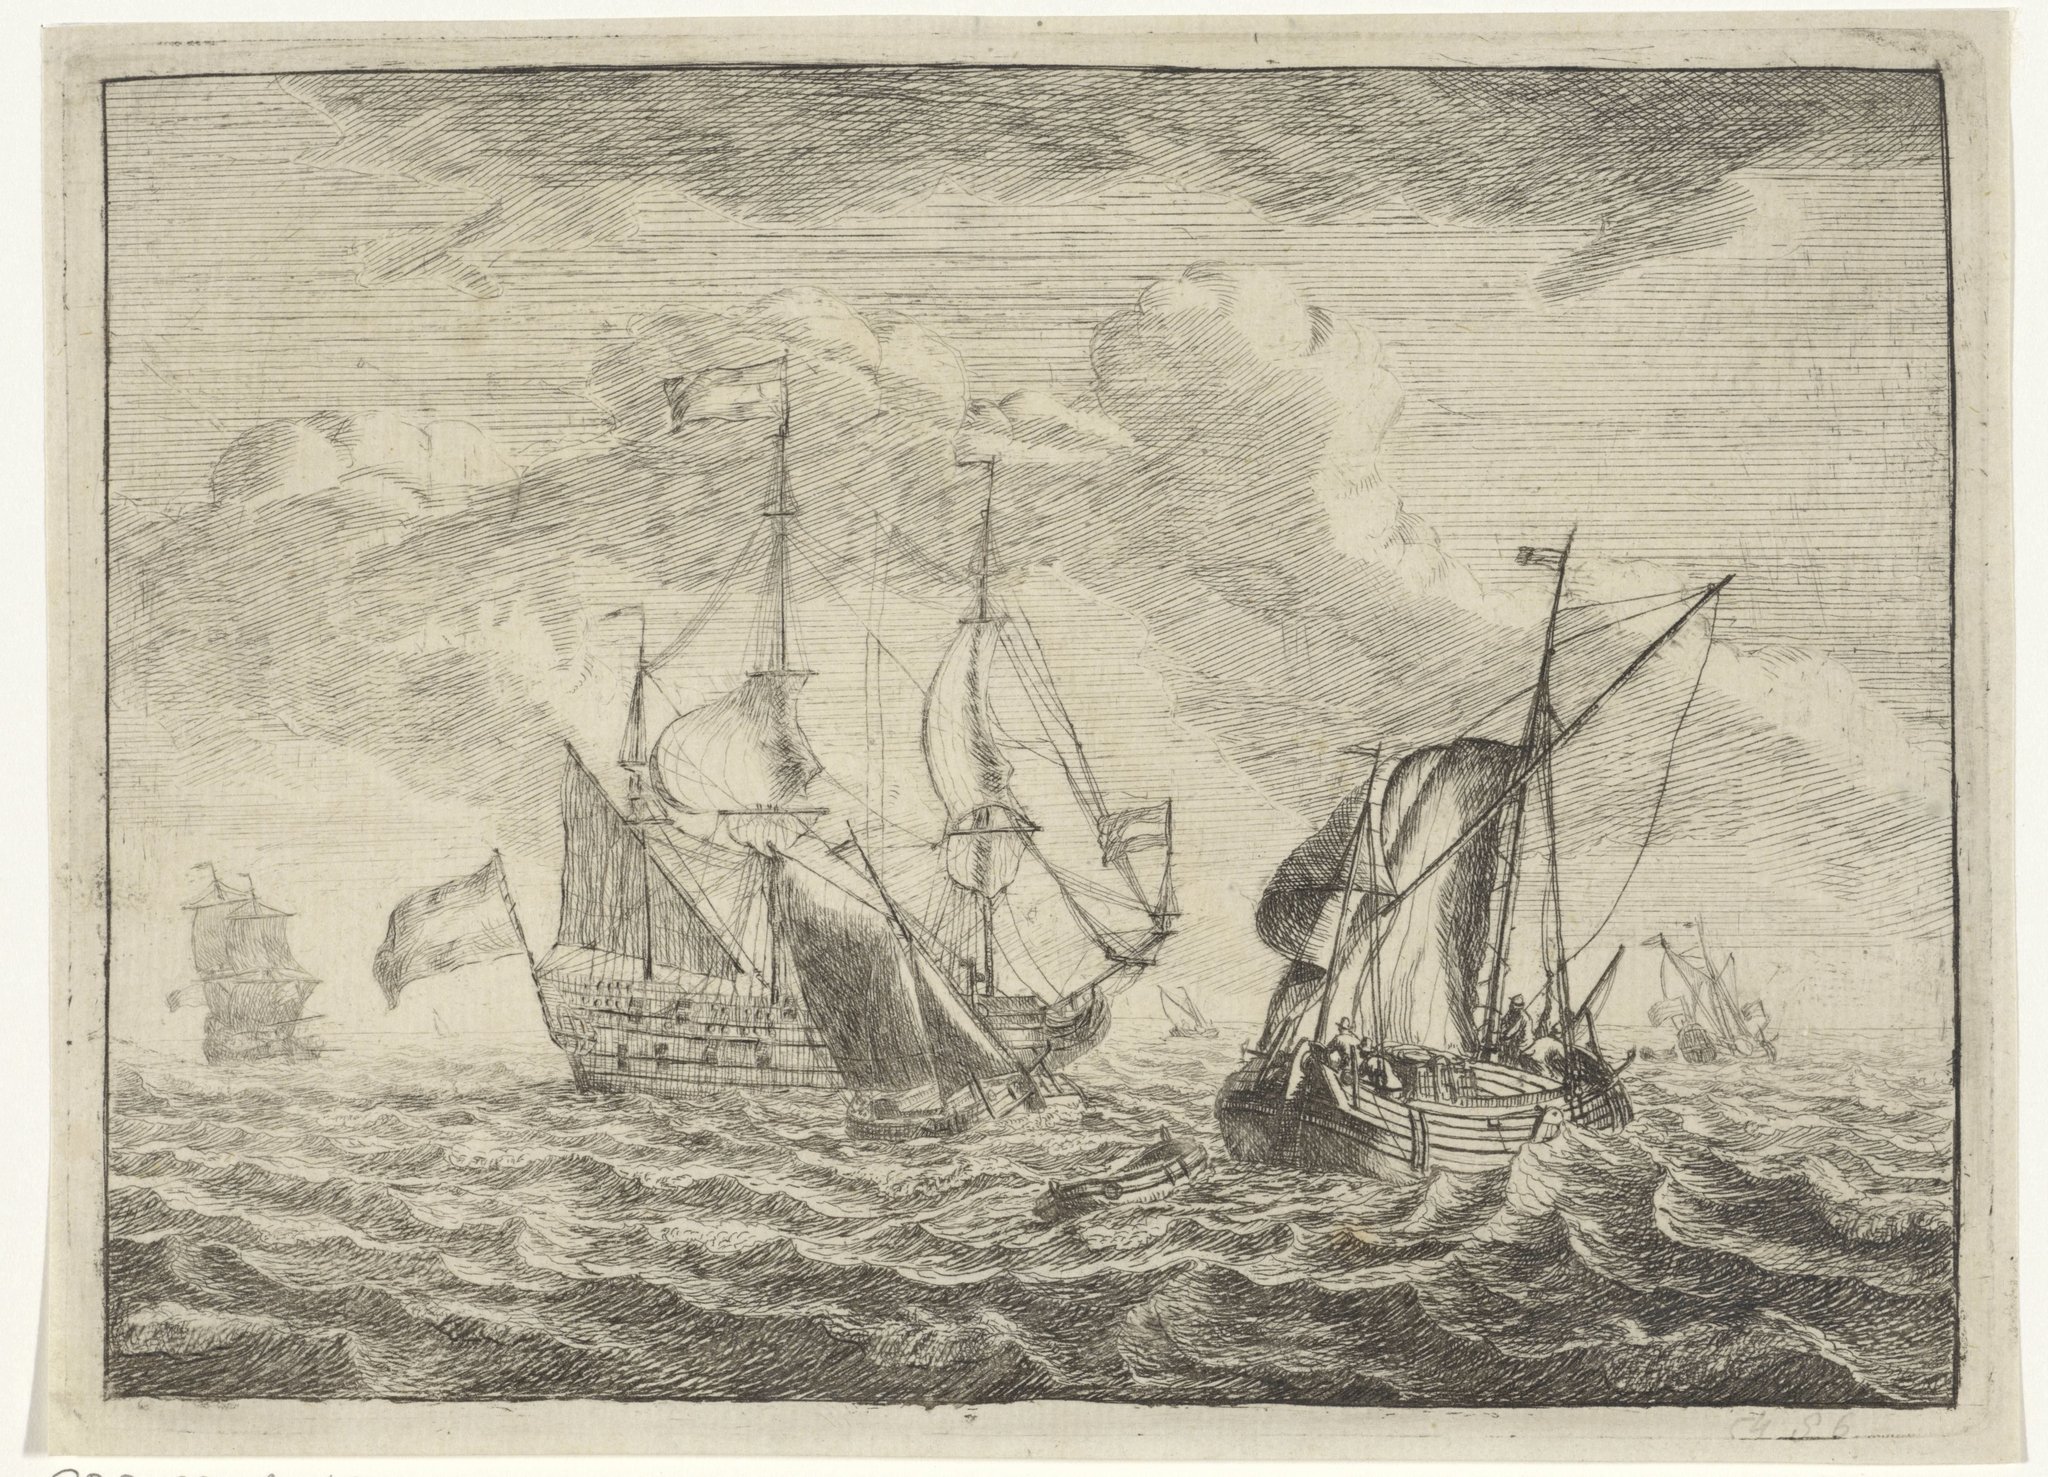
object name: print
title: Zeegezicht met twee- en driemasters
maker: adam silo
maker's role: print maker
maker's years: 1674-1760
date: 1689-1760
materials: paper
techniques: etching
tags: sea (seascape)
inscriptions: collector's mark: Lugt 2228